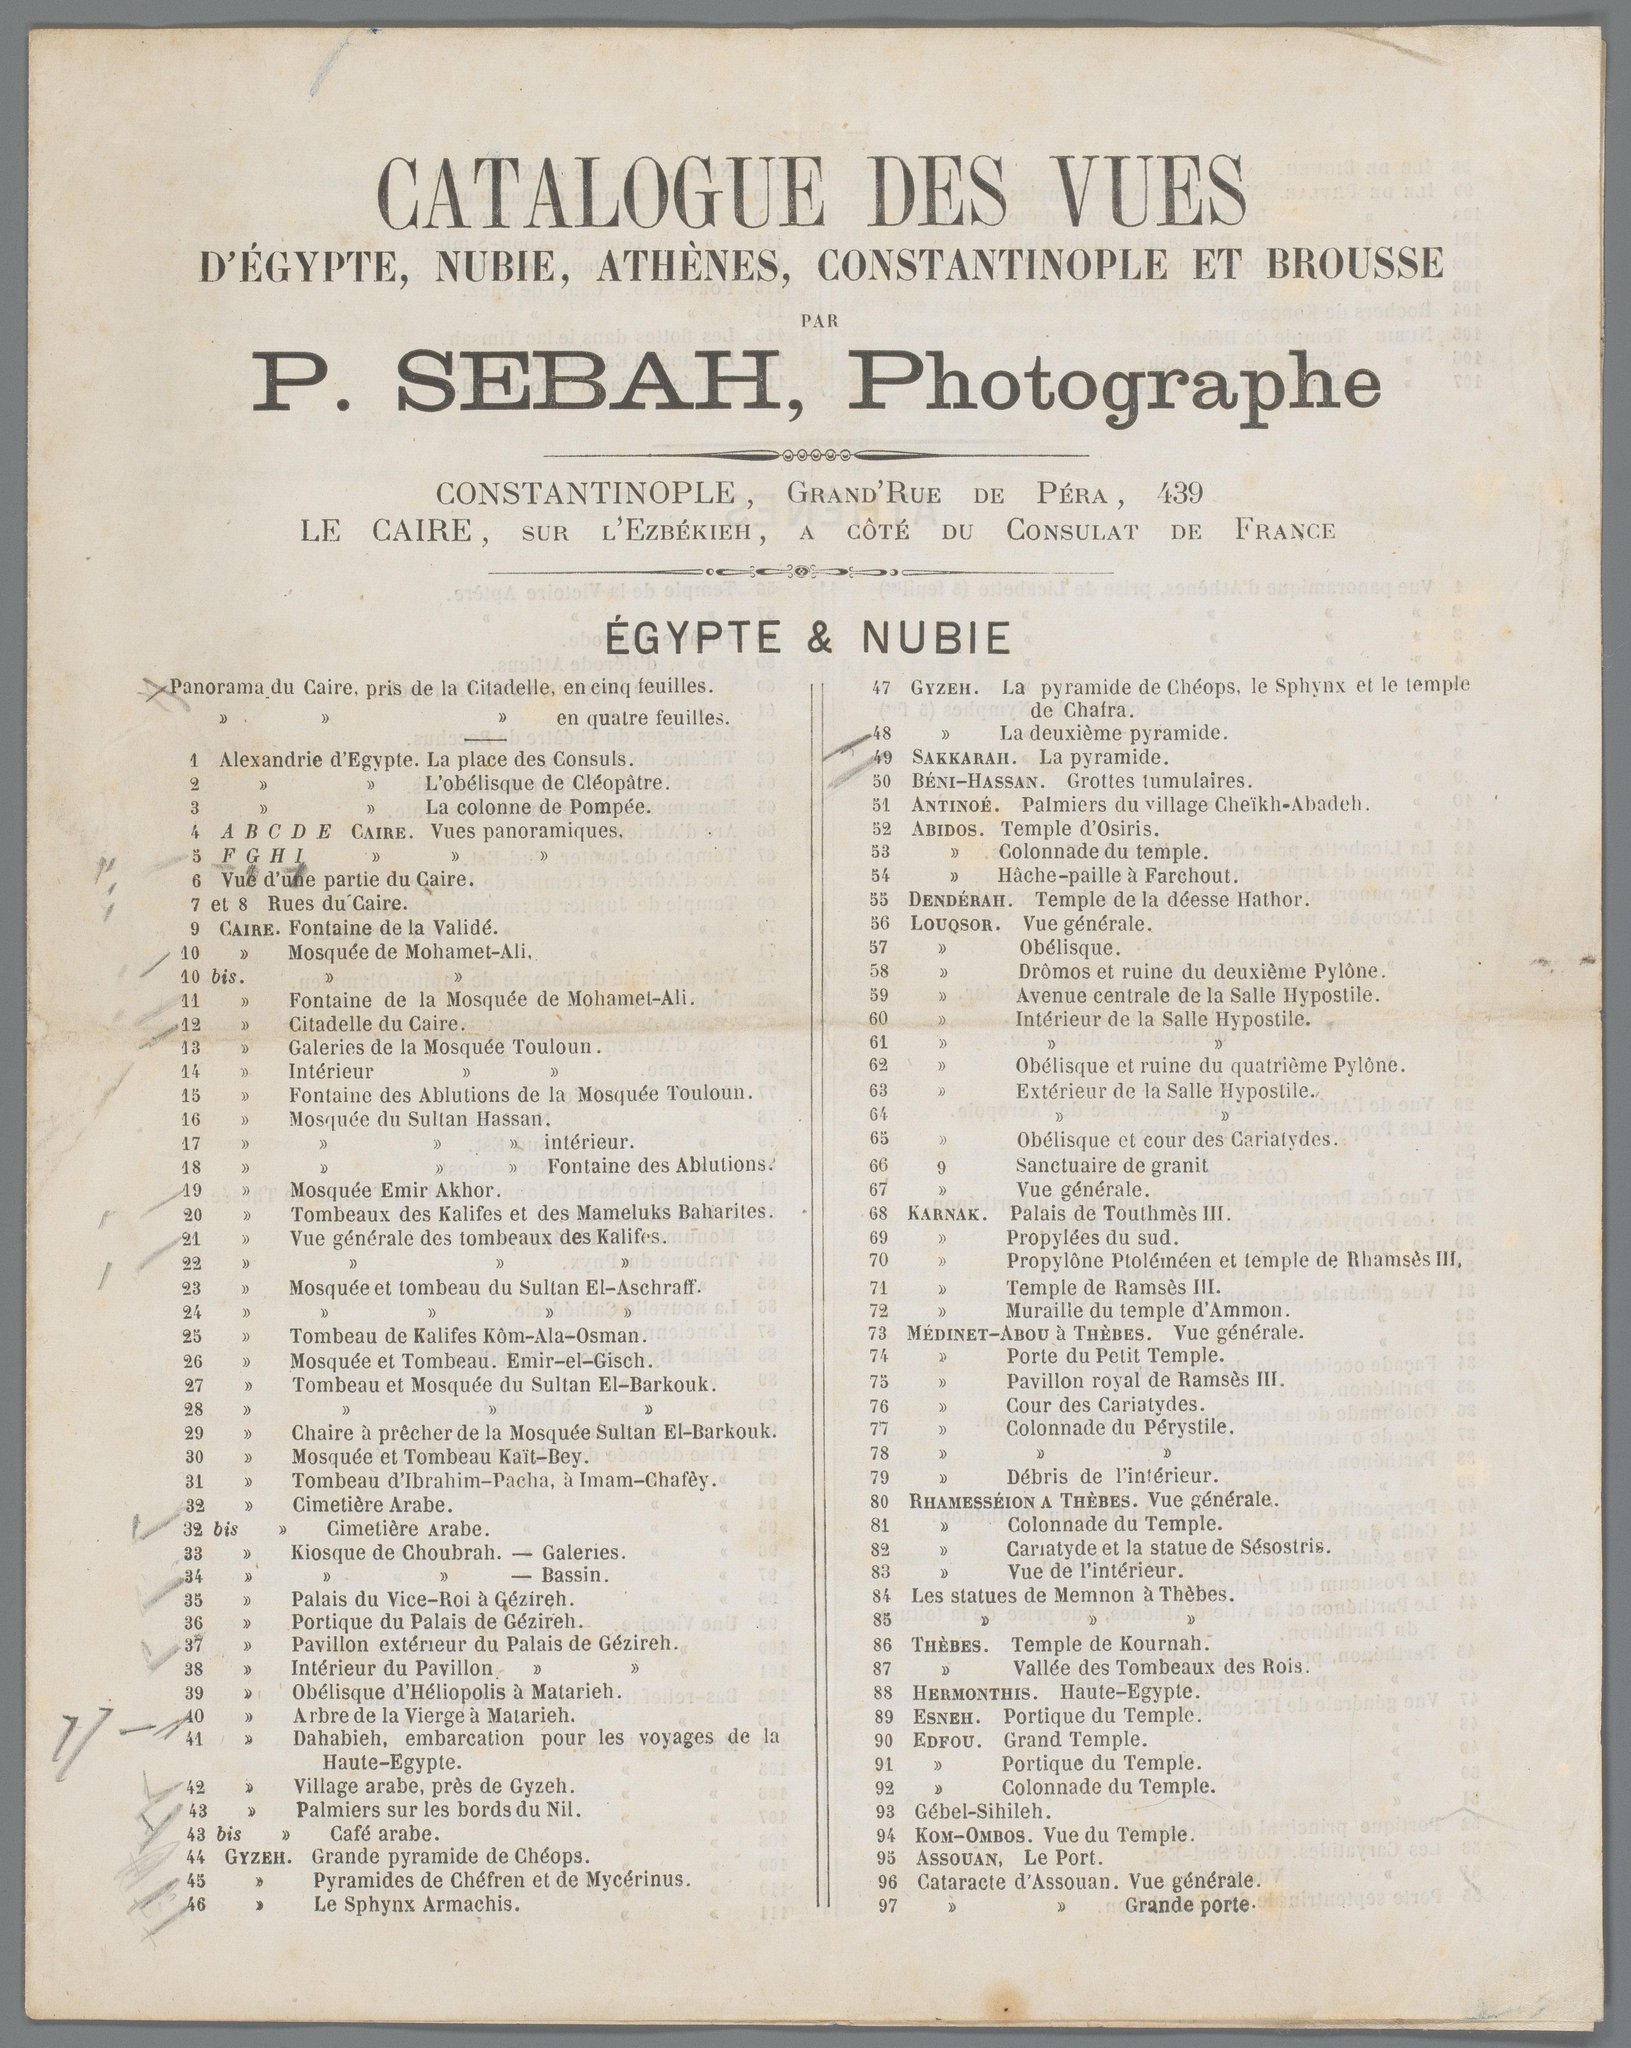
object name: fondslijst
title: Handelscatalogus met 117 titels van foto's van onder meer Egypte en Nubië, van de fotograaf Pascal Sébah.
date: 1875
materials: paper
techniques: letterpress printing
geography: cairo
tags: printed matter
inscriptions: address: ‘CONSTANTINOPLE, Grand'Rue de Péra, 439/ LE CAIRE, sur l'Ezbékieh, a côté du Consult de France’